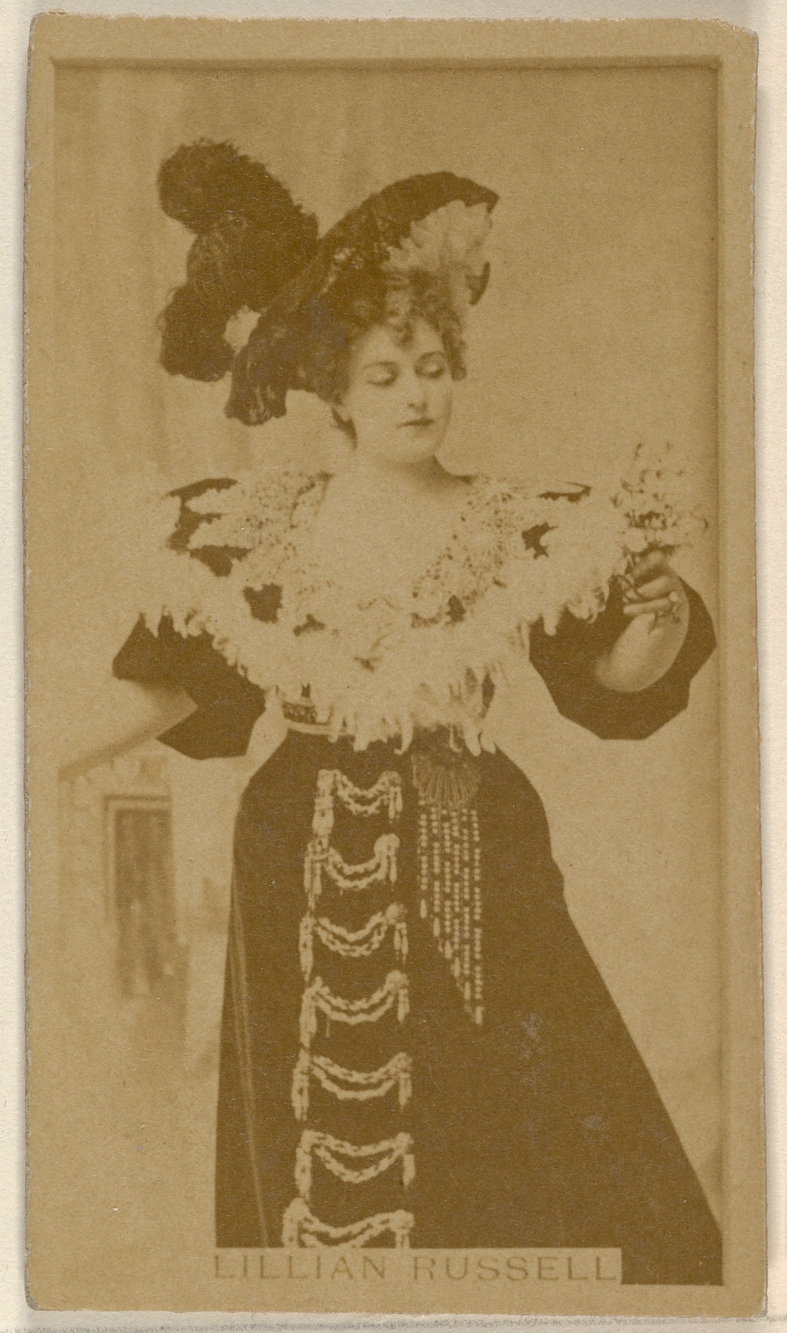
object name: photograph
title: Lillian Russell, from the Actors and Actresses series (N45, Type 8) for Virginia Brights Cigarettes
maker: allen & ginter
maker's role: publisher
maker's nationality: american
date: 1888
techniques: albumen silver print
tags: portraits,women,actresses